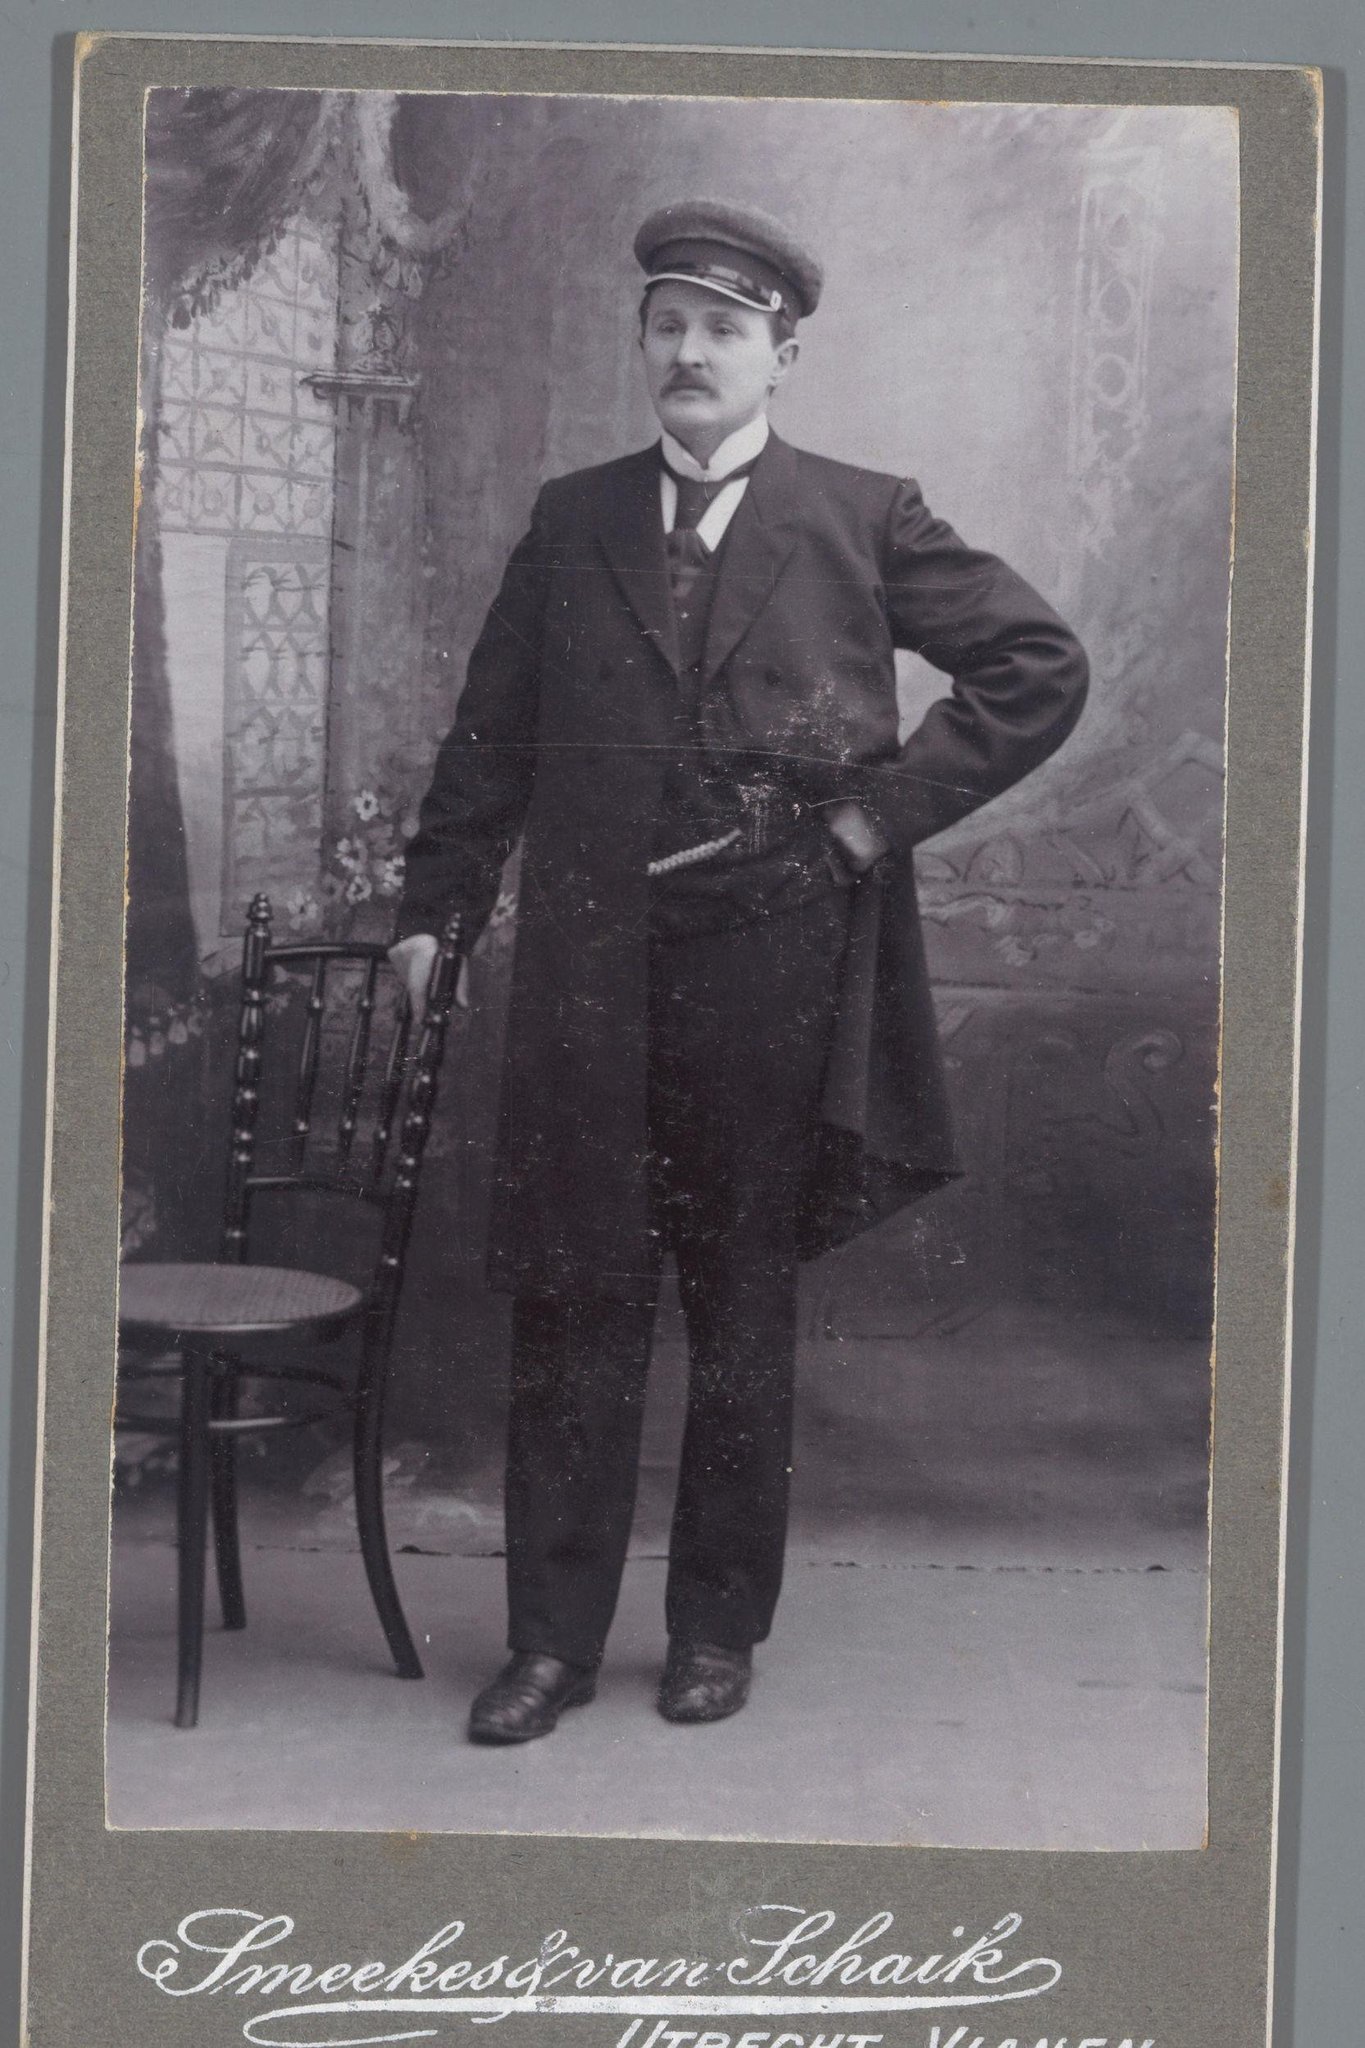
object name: carte de visite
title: Portret van een onbekende man met pet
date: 1900-1924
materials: cardboard, photographic support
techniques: collodion silver print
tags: adult man, historical persons, head-gear: cap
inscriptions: inscription: ‘FOTOGRAFISCHE/ ATELIERS/ van/ Smeekes & van Schaik/ Leidschekade 19/ UTRECHT/ VIANEN/ Voorstraat.’